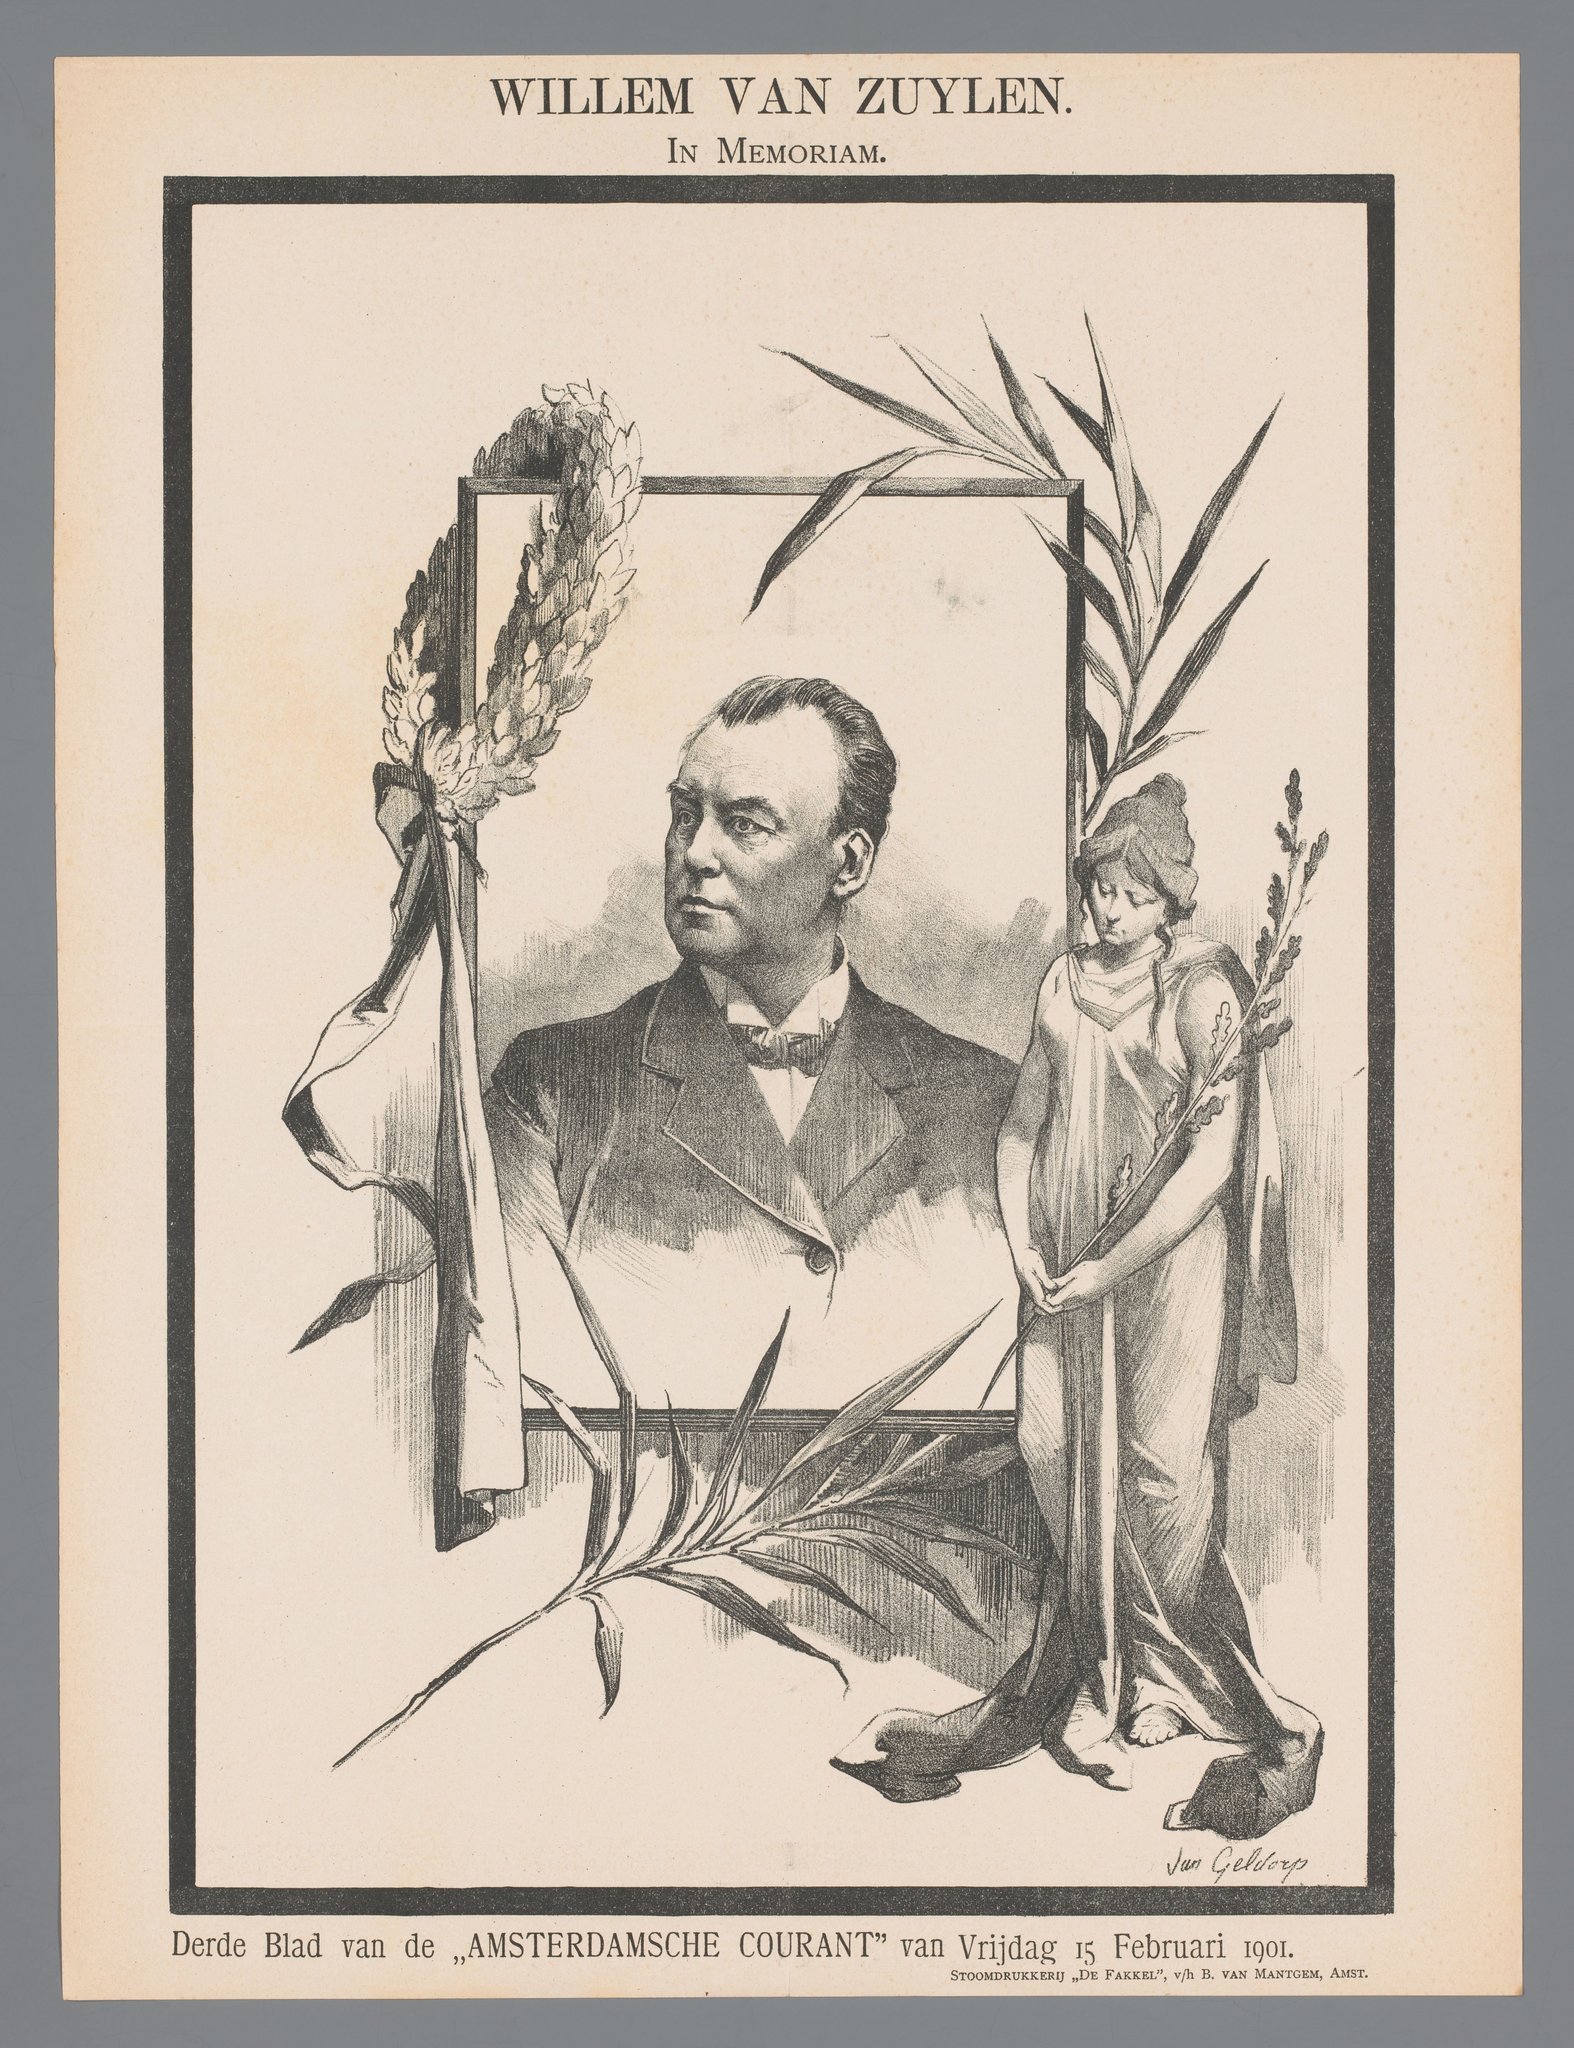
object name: print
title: Willem van Zuylen In Memoriam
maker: petrus van geldorp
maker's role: draughtsman, print maker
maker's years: 1872-1939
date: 1901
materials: paper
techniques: lithograph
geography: amsterdam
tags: rotterdam, historical persons, portrait of actor, actress, 'in memoriam'-card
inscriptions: date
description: Prent uit het bijvoegsel van: De Amsterdamsche Courant, 15 februari 1901.